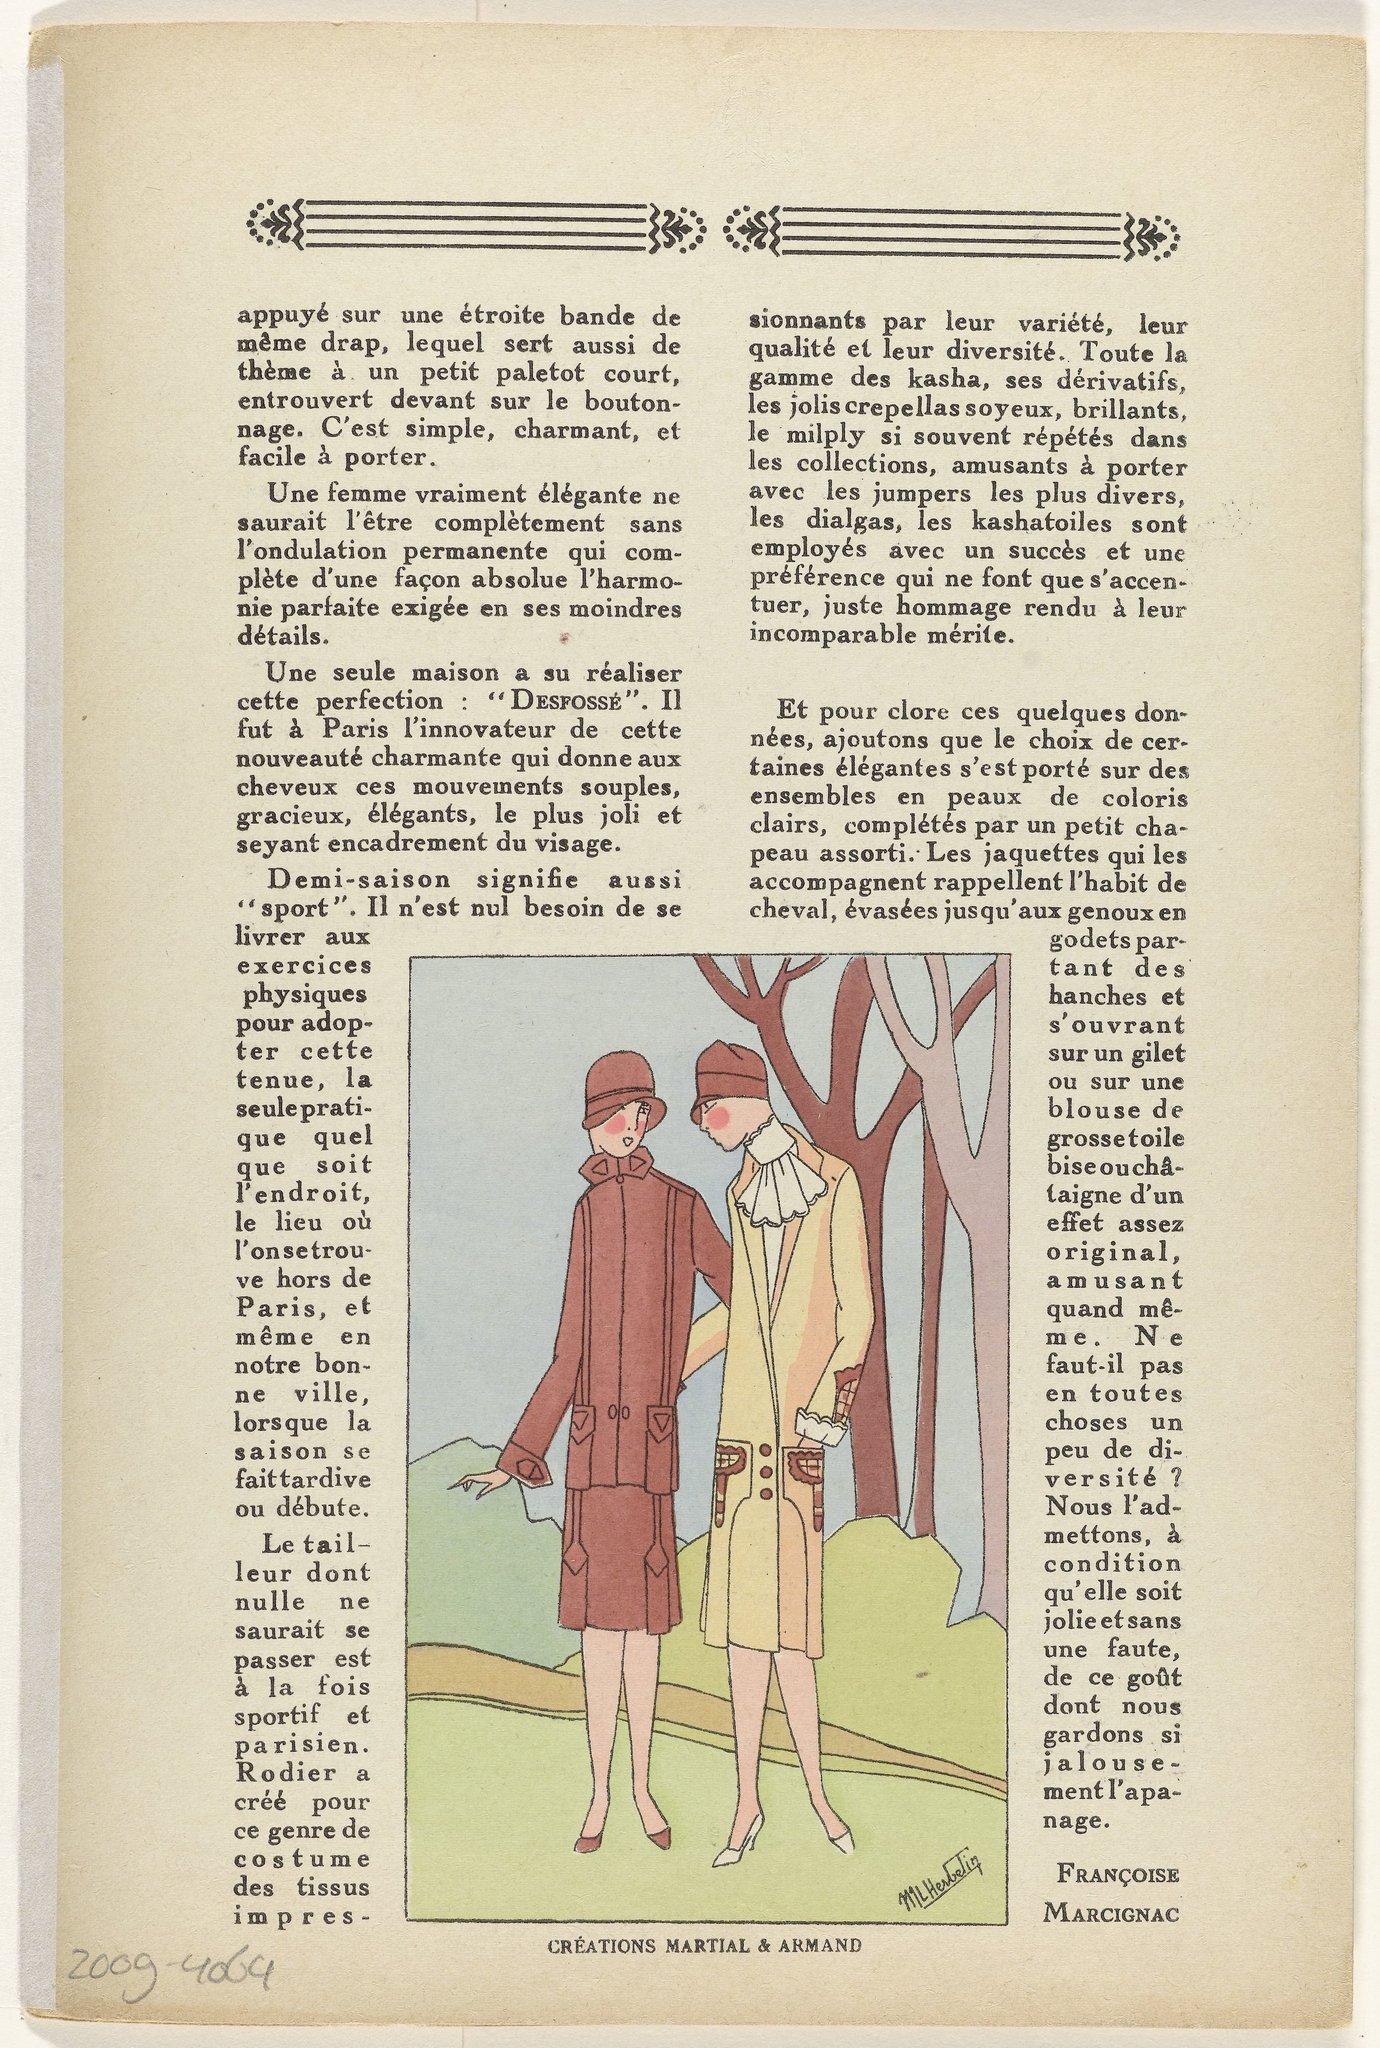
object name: fashion print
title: Très Parisien, 1927 : CRÉATIONS MARTIAL & ARMAND (...)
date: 1927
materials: paper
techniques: hand coloring, letterpress printing, pochoir, lithography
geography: paris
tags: clothing for the upper part of the body (+ women's clothes), coat (+ women's clothes), fashion plates, skirt (+ women's clothes)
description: Een pagina met illustratie uit Très Parisien. Creaties van Martial & Armand. Prent uit het modetijdschrift Très Parisien (1920-1936).